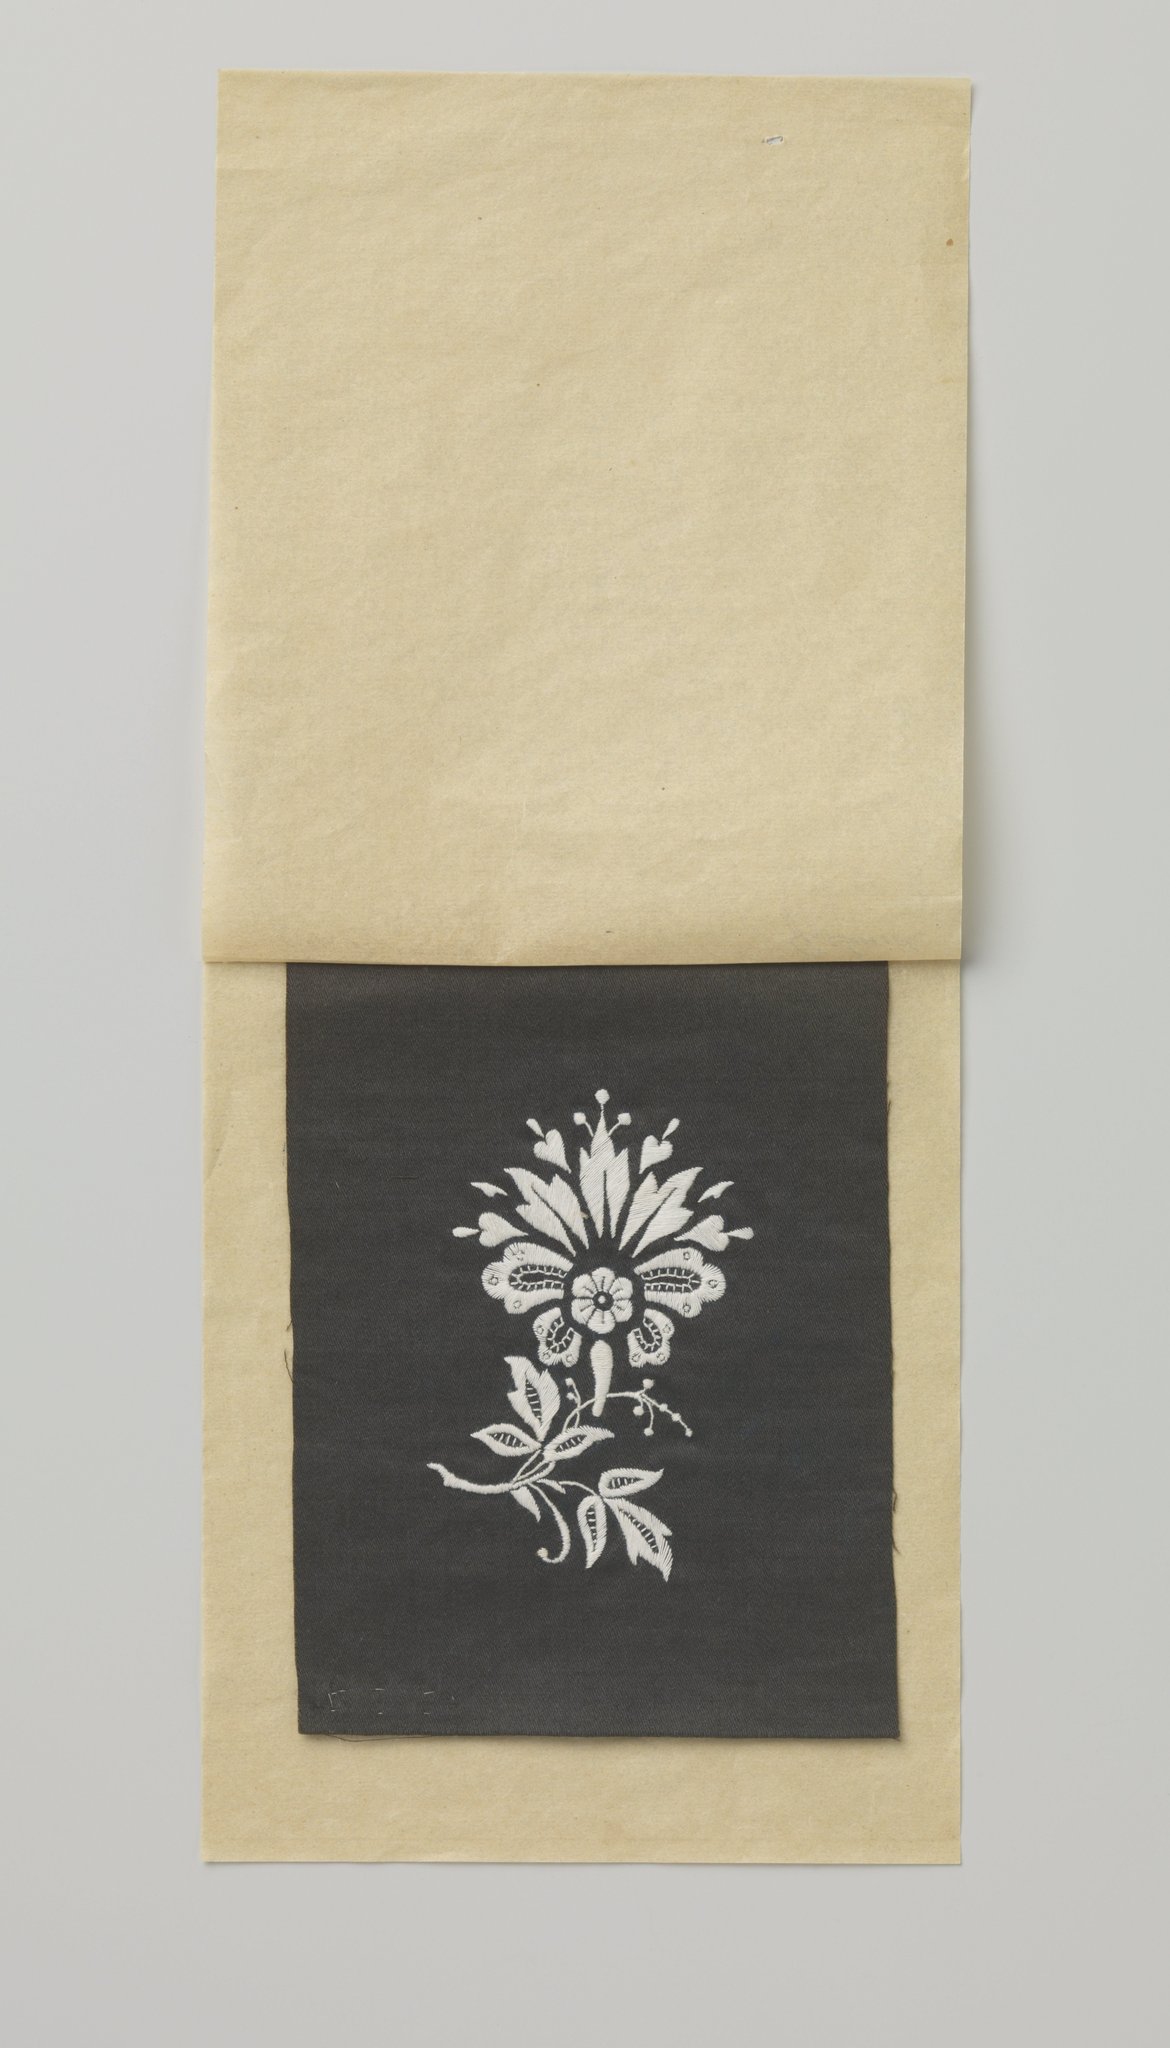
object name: werkstuk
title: Werkstuk voor Diploma fraaie handwerken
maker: geesje smid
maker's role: artisan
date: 1890-1900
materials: cotton, textile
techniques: embroidered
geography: netherlands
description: Stukje zwart katoenen satijn met bloemtakje geborduurd in wit.